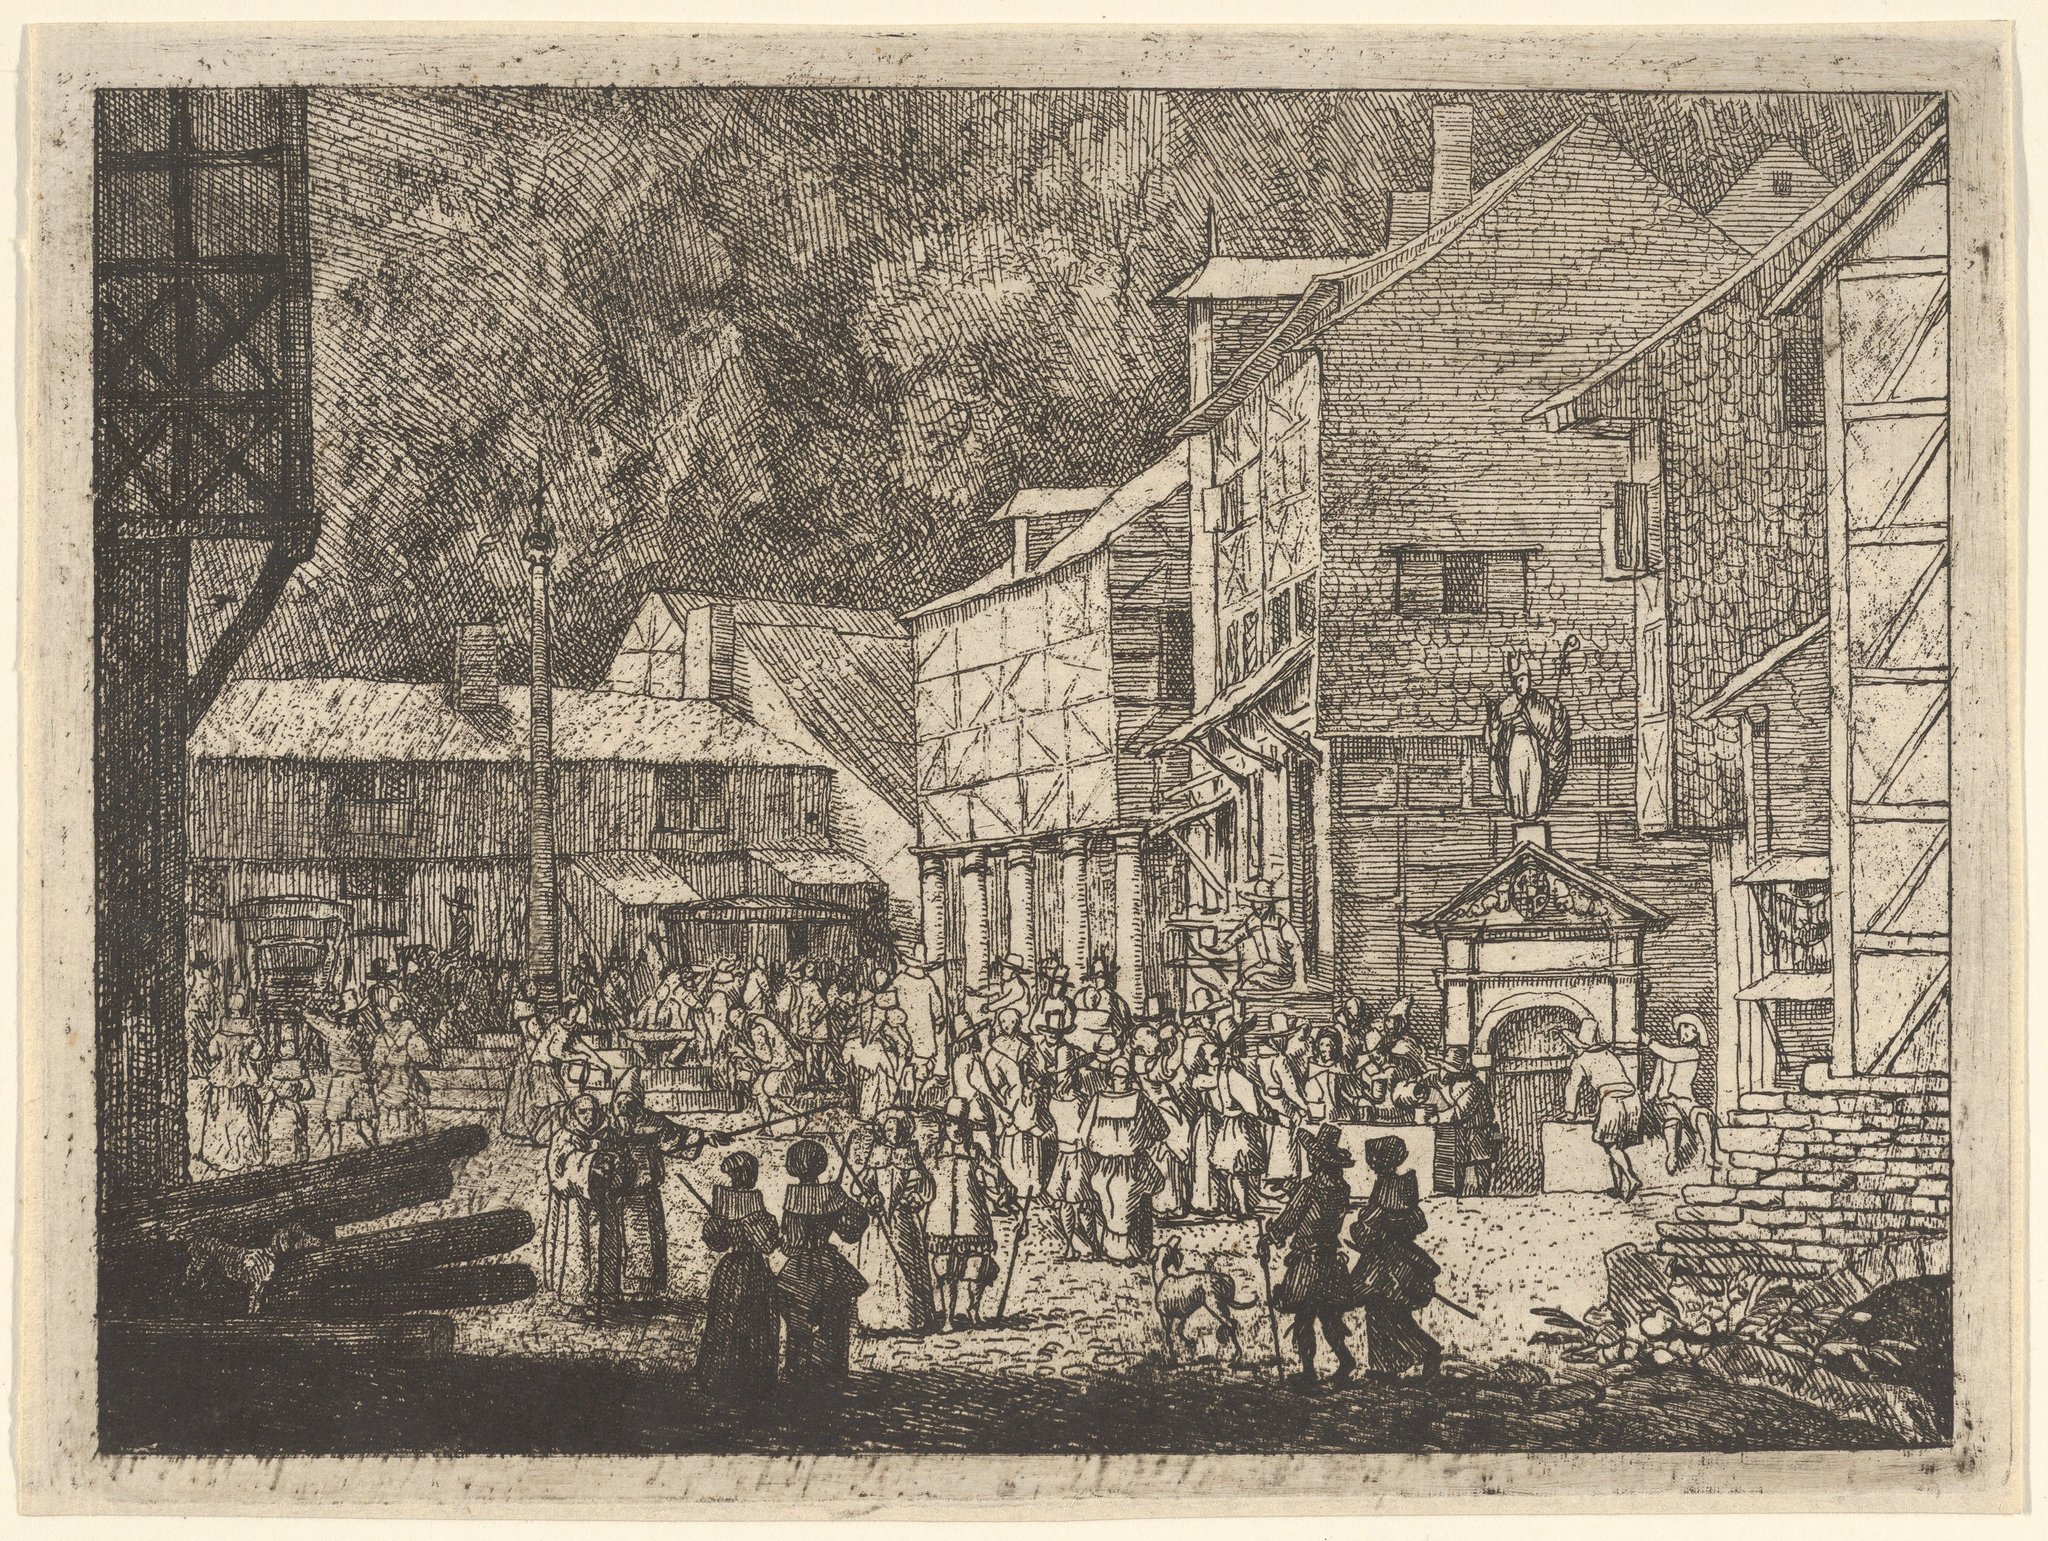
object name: print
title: The Second Spring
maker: allart van everdingen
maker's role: artist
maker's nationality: dutch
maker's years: 1621-1675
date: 1621-1675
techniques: engraving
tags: towns,crowd